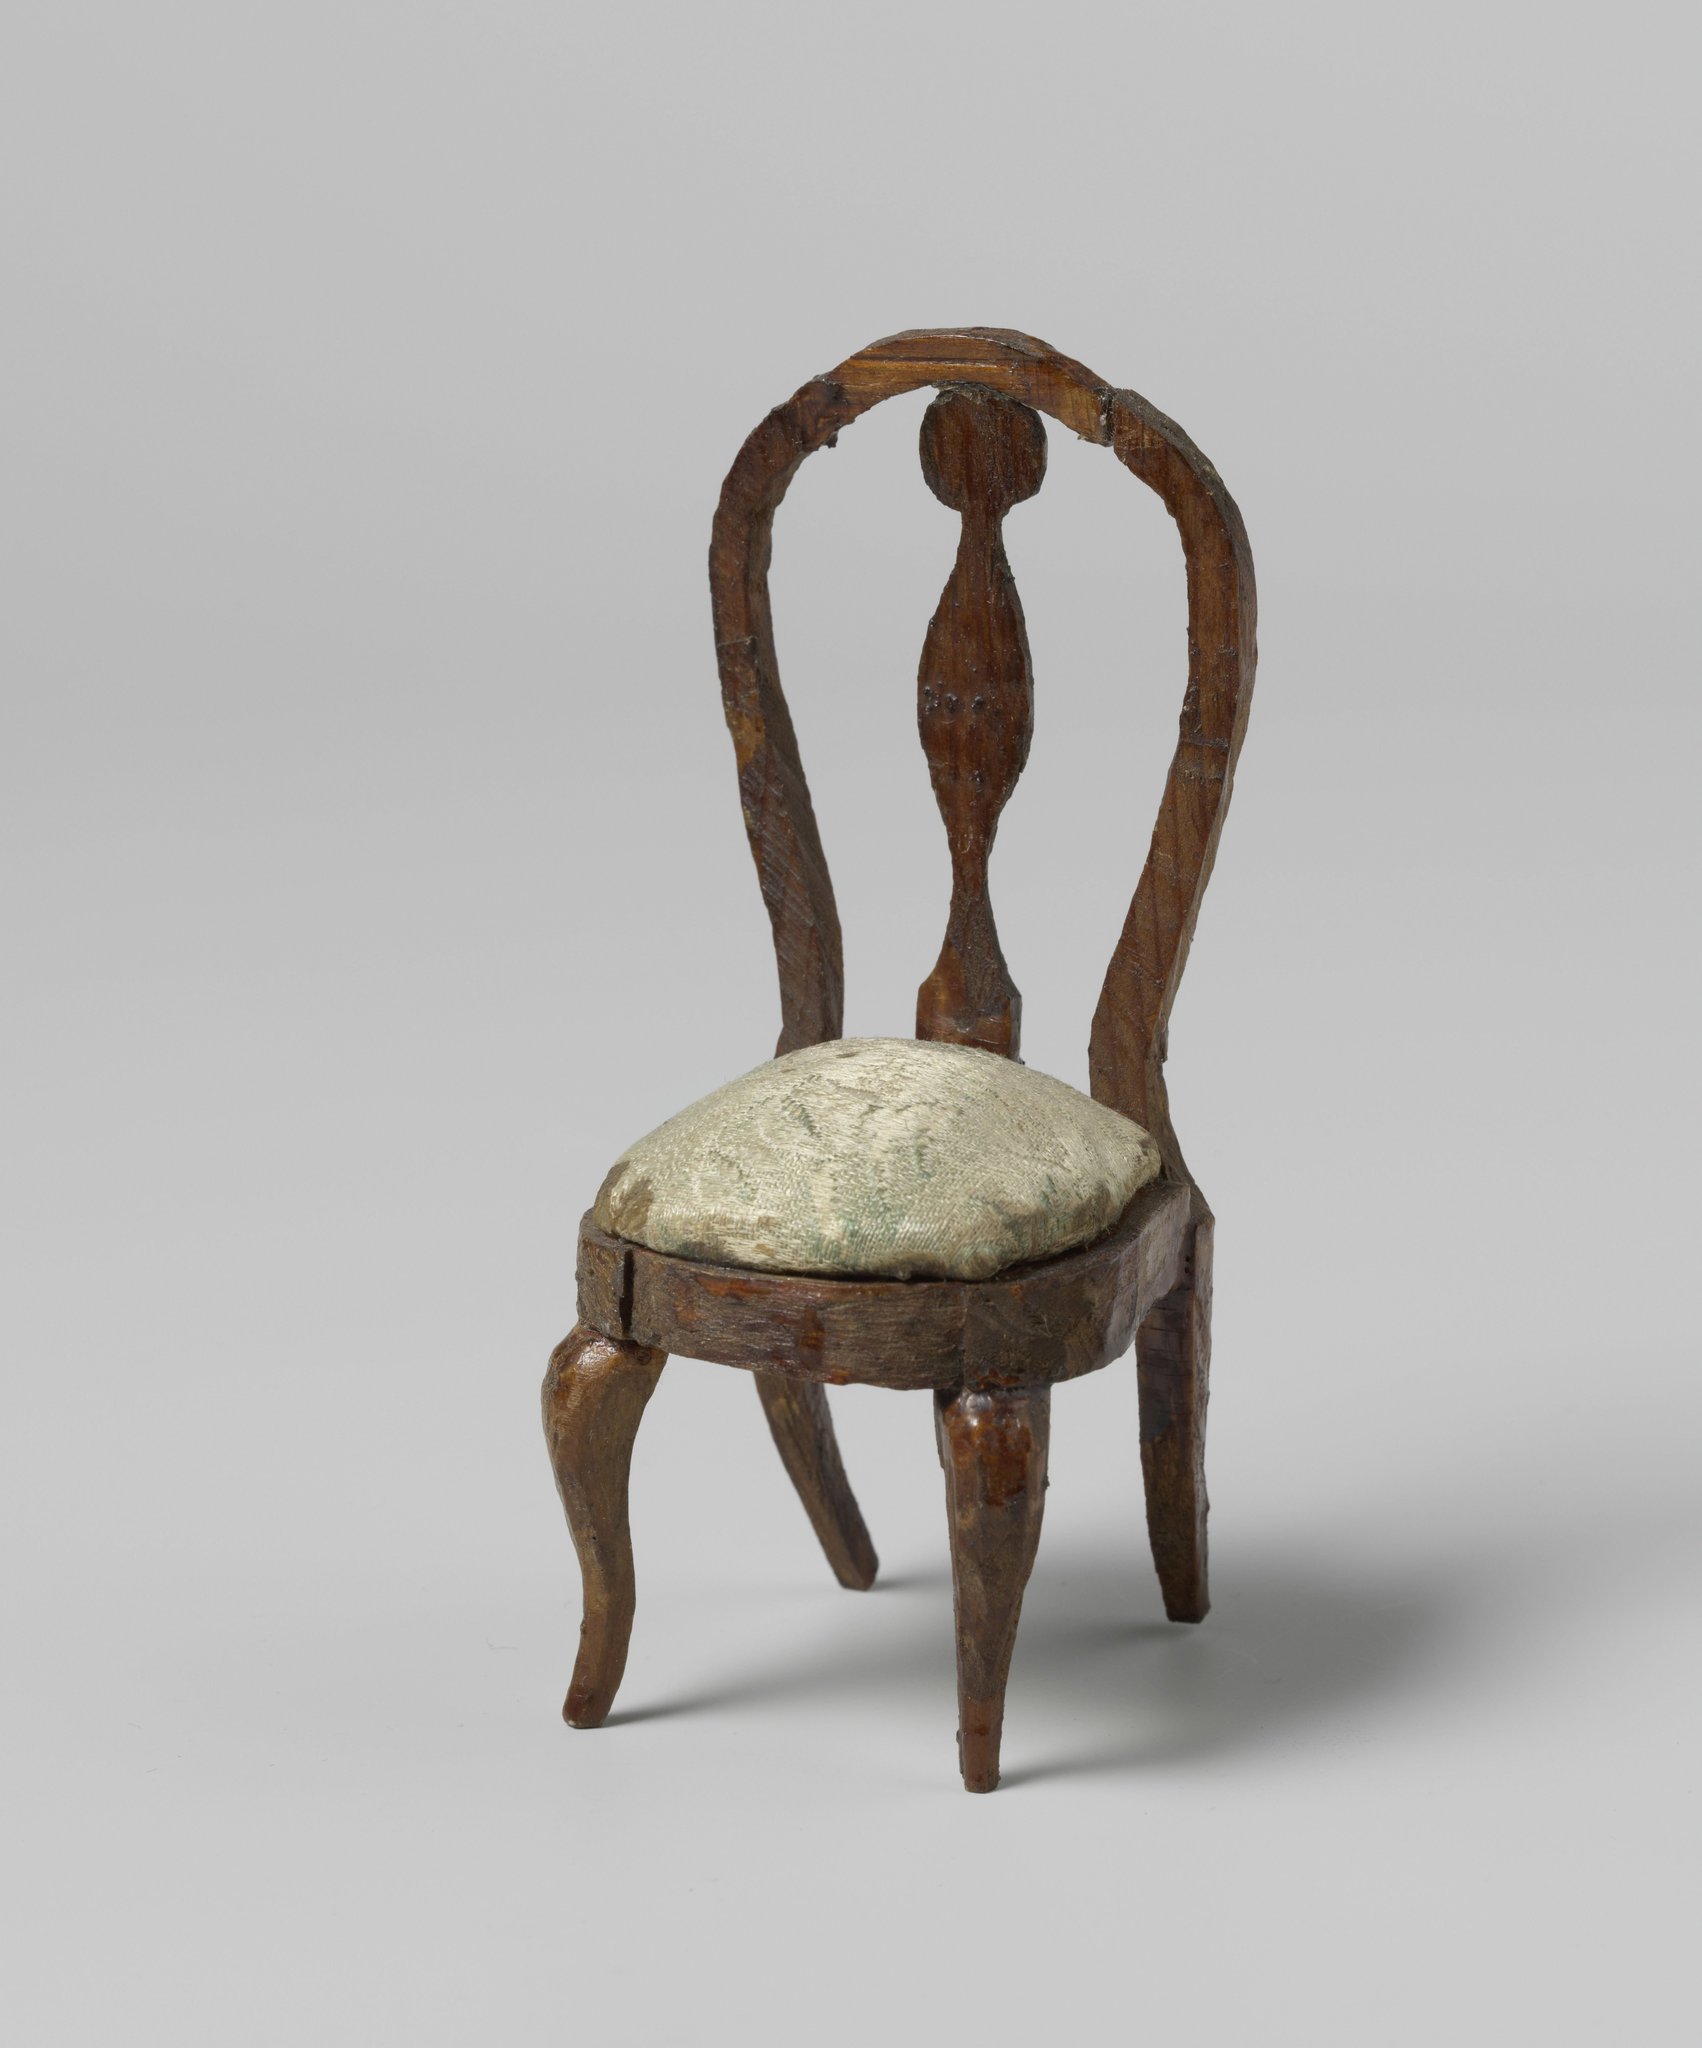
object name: chair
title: Stoel met ronde, open rugleuningen met middenstijl, de zitting met bloem- en bladmotieven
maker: Anonymous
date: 1750-1800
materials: silk, wood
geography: amsterdam